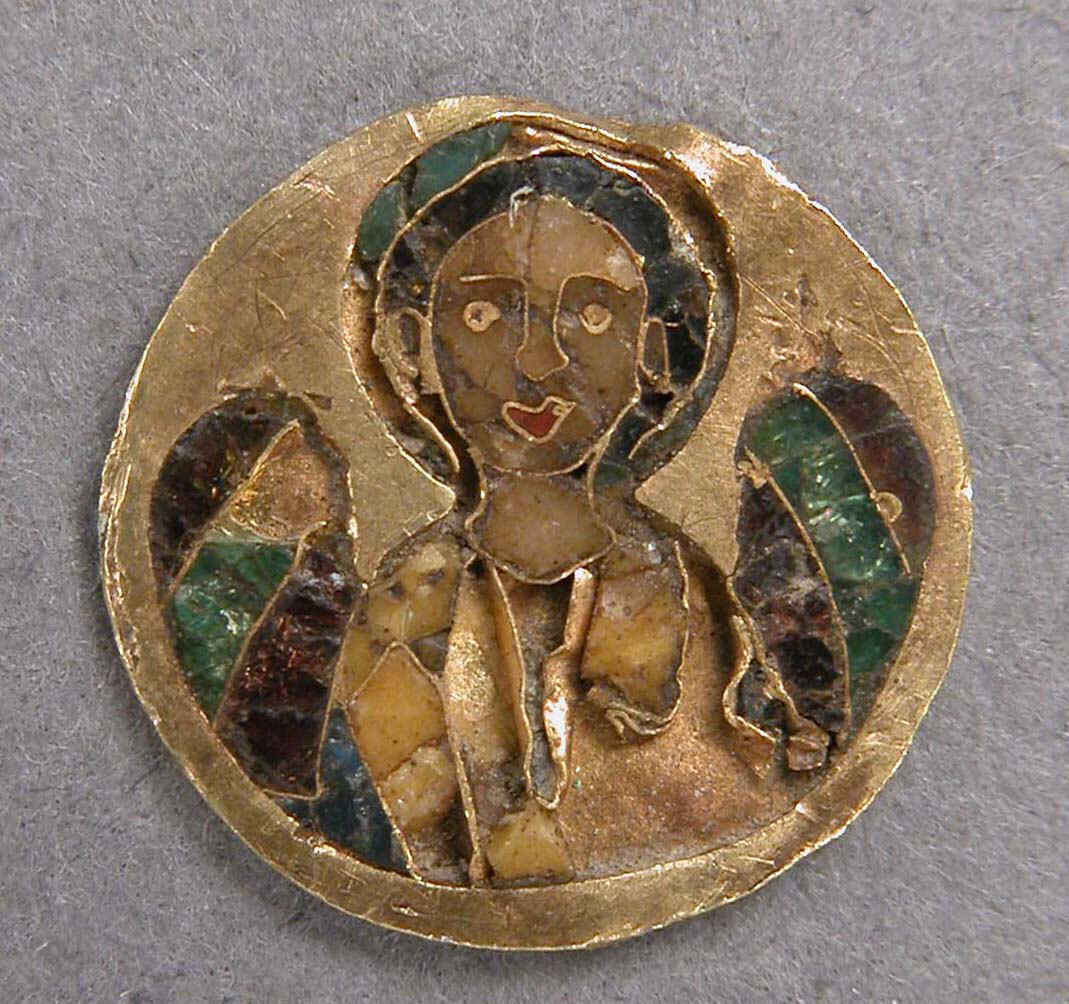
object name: medallion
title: Medallion with an Archangel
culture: byzantine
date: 1001-1100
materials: enamel, gold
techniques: enamel